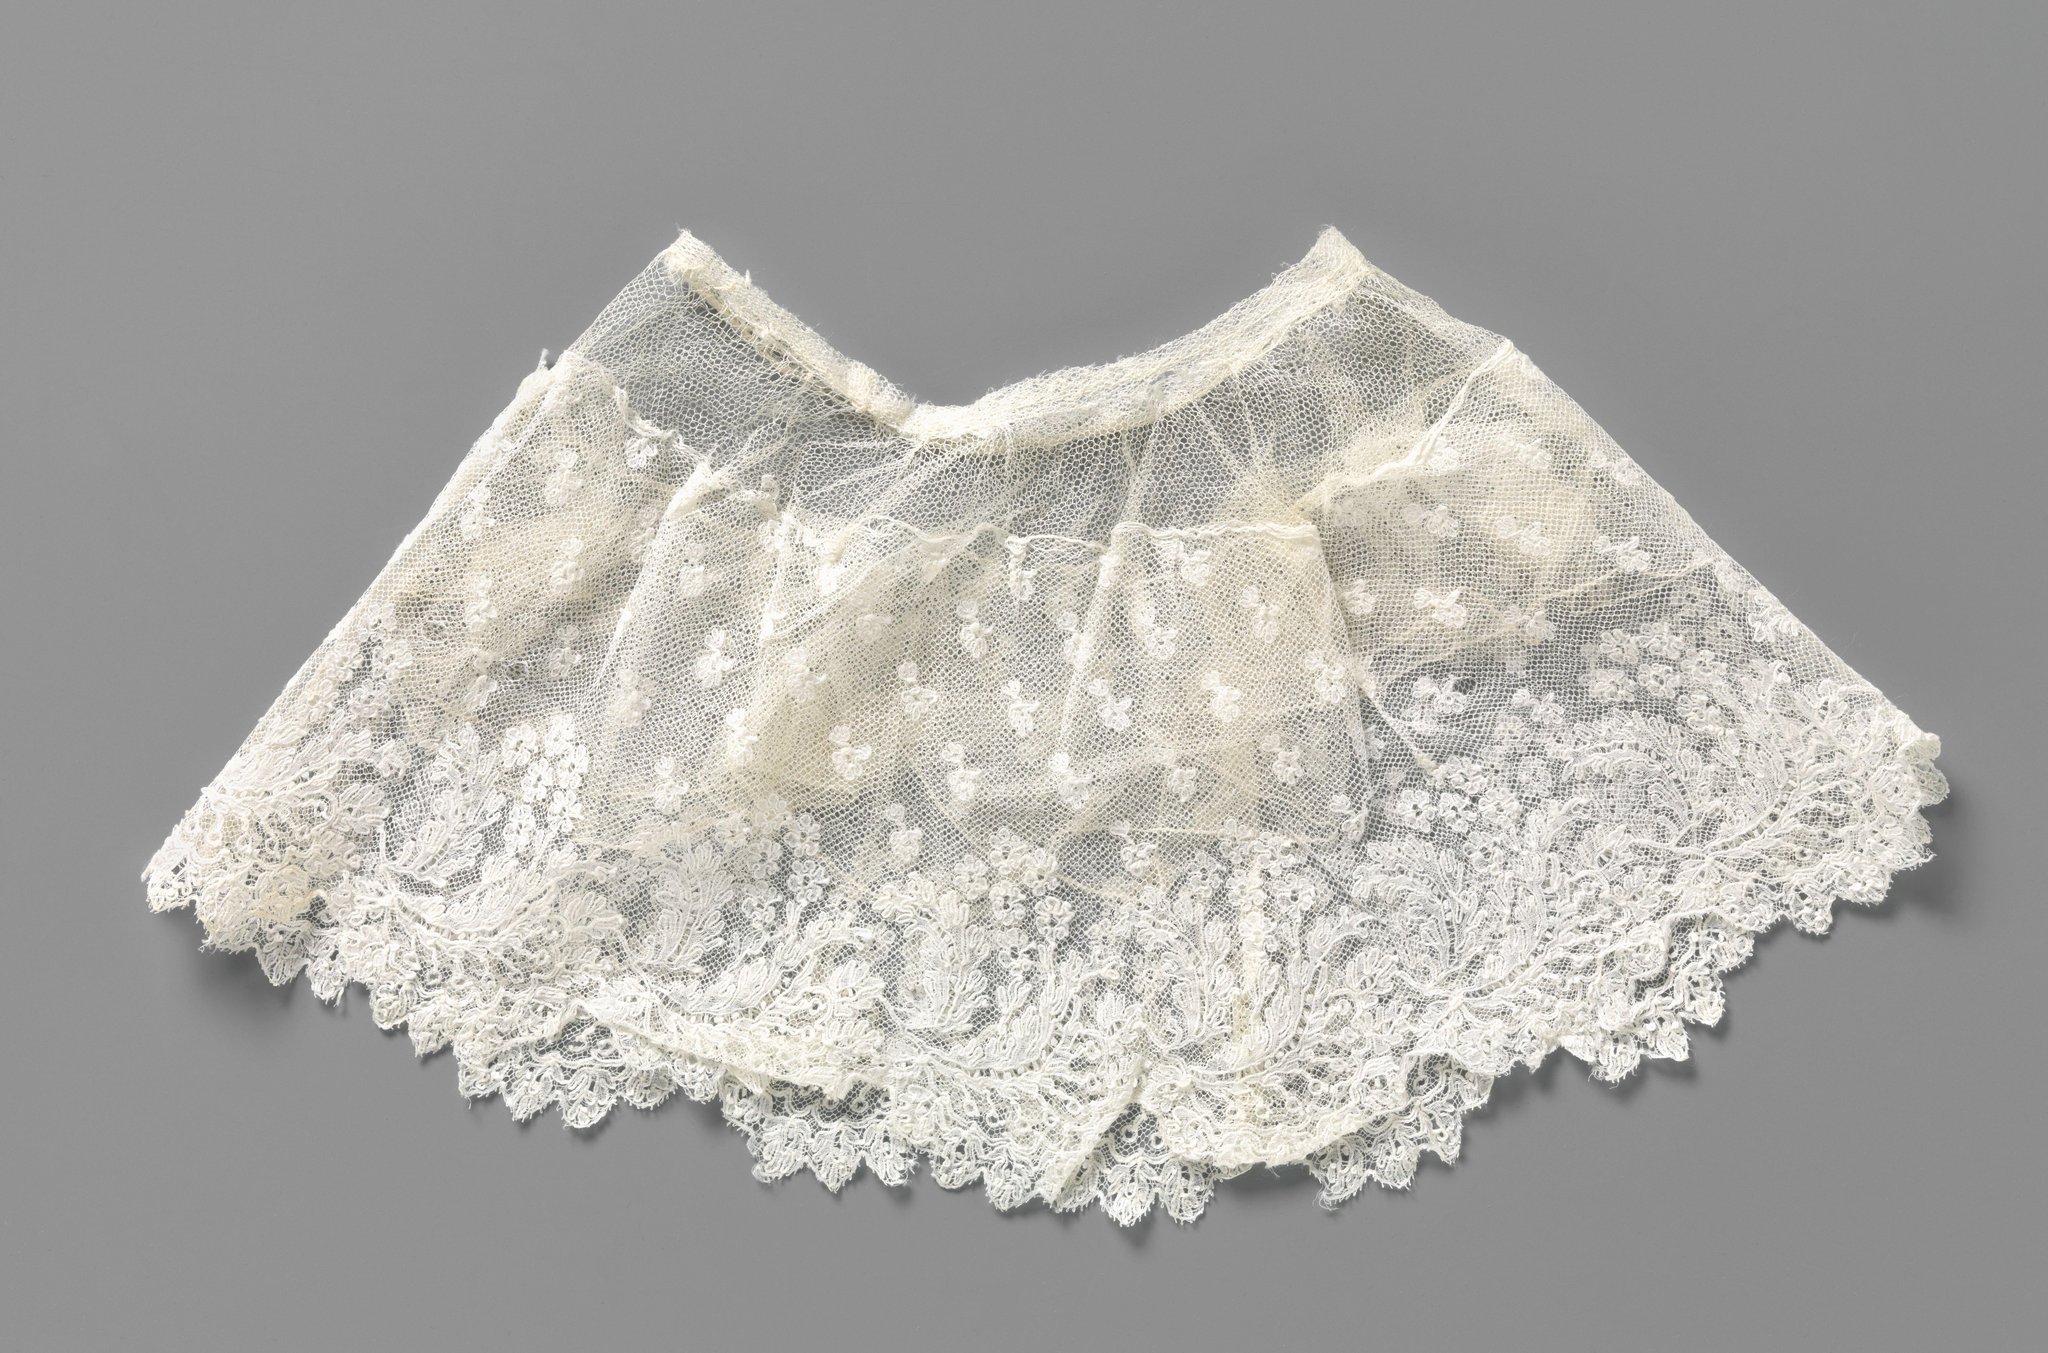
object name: womenswear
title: Manchet van kloskant met sikkelvormige blad- en bloemtakken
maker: Anonymous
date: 1830-1865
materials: linen, silk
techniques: lace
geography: amsterdam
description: Manchet van naturelkleurige tule met daaronder een rand kloskant: Mechelse kant. De tule is onversierd en iets donkerder van tint dan de Mechelse kant die aan de tule is genaaid. Trapezium vormig klokkend model. Het zich herhalende patroon van de Mechelse kant bestaat uit halfronde schulpen, gevormd door fijne bladeren die aan de buitenzijde van een gebogen rocaille-motief staan. Aan de binnenzijde gevederde lange bladeren en een groepje van zes rozetbloempjes of vergeet-mij-nietjes. Op het veld daarboven gestrooide bloesems. De motieven zijn gemaakt in linnenslag en worden geaccentueerd door dikkere glimmende contourdraden. De motieven zijn met elkaar verbonden door een Mechelse grond. In de bladeren is een versiering met stipjes gemaakt in vormslag. Het kant is gemaakt in België, de manchetten zijn gemaakt in Nederland.